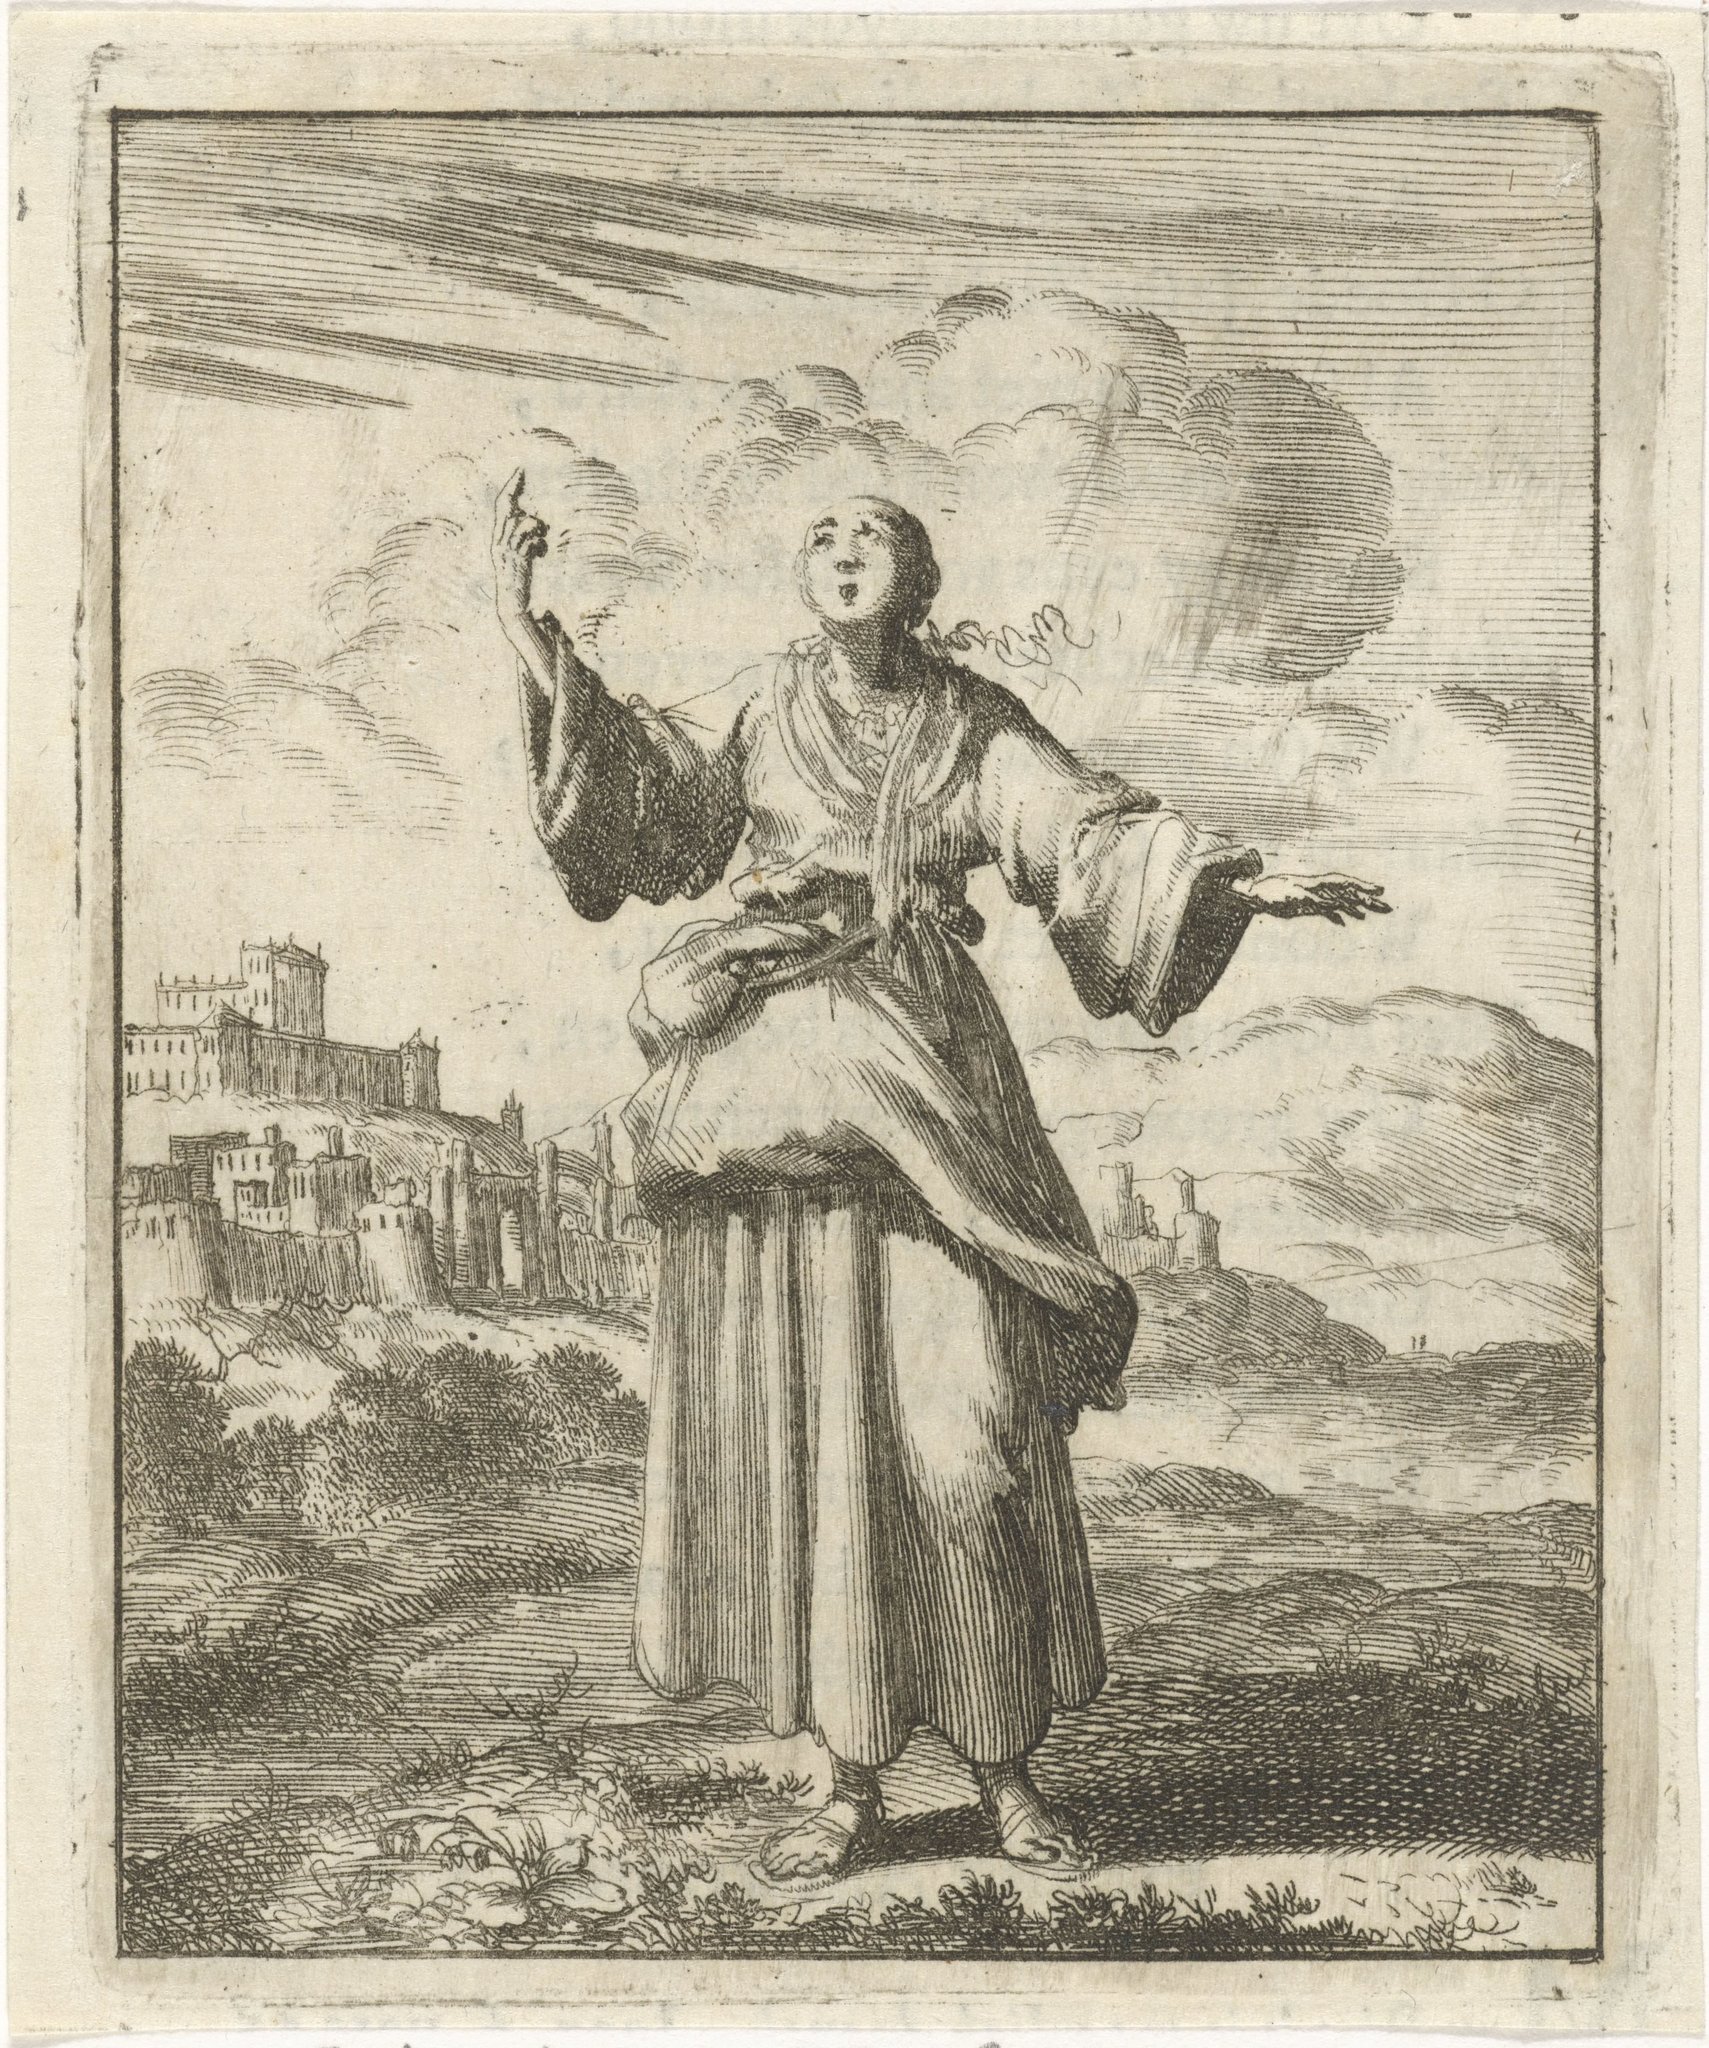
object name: book illustration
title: Vrouw wijzend naar de hemel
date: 1687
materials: paper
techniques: etching, letterpress printing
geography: amsterdam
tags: firmament, sky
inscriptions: collector's mark: Lugt 2228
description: Illustratie uit: Luyken, Jan. Voncken der liefde Jesu, van het godtbegerende zielenvier. Amsterdam: Pieter Arentsz (II), 1687, p. 178.